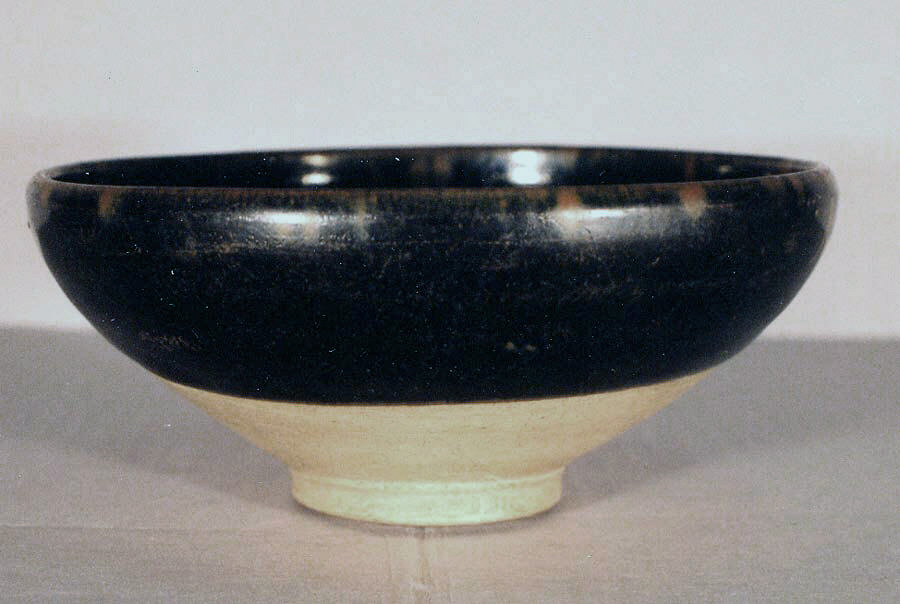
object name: bowl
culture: chinese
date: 1201-1400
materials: glaze, stoneware